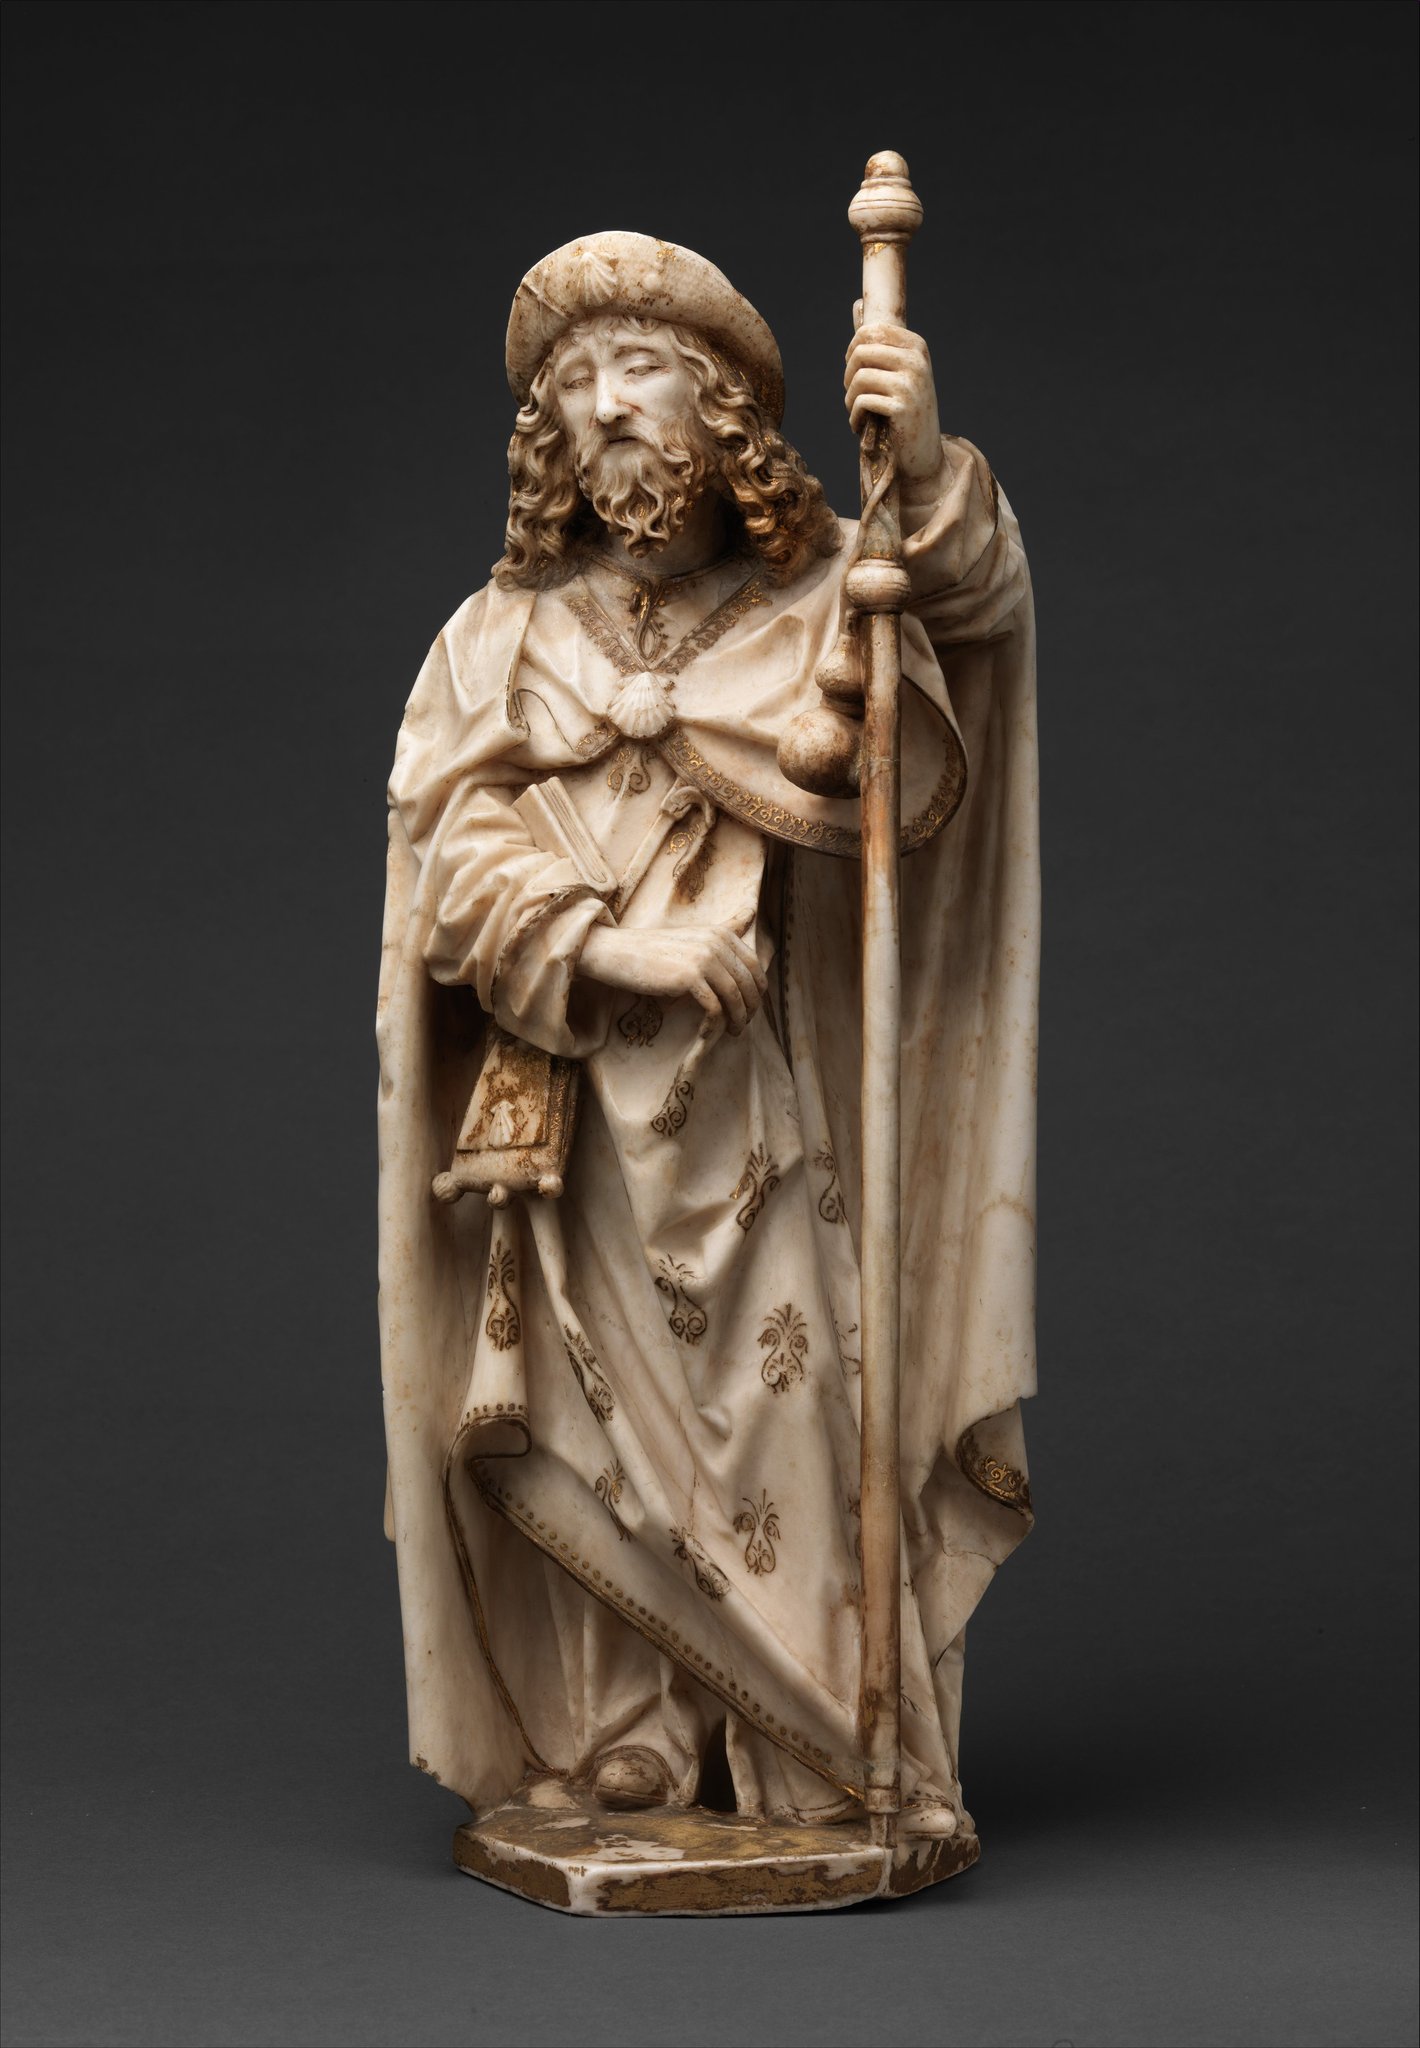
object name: statuette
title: Saint James the Greater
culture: spanish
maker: gil de siloe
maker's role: artist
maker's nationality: spanish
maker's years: 1475-1505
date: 1489-1493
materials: alabaster, paint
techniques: gilding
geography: spain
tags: men,saints